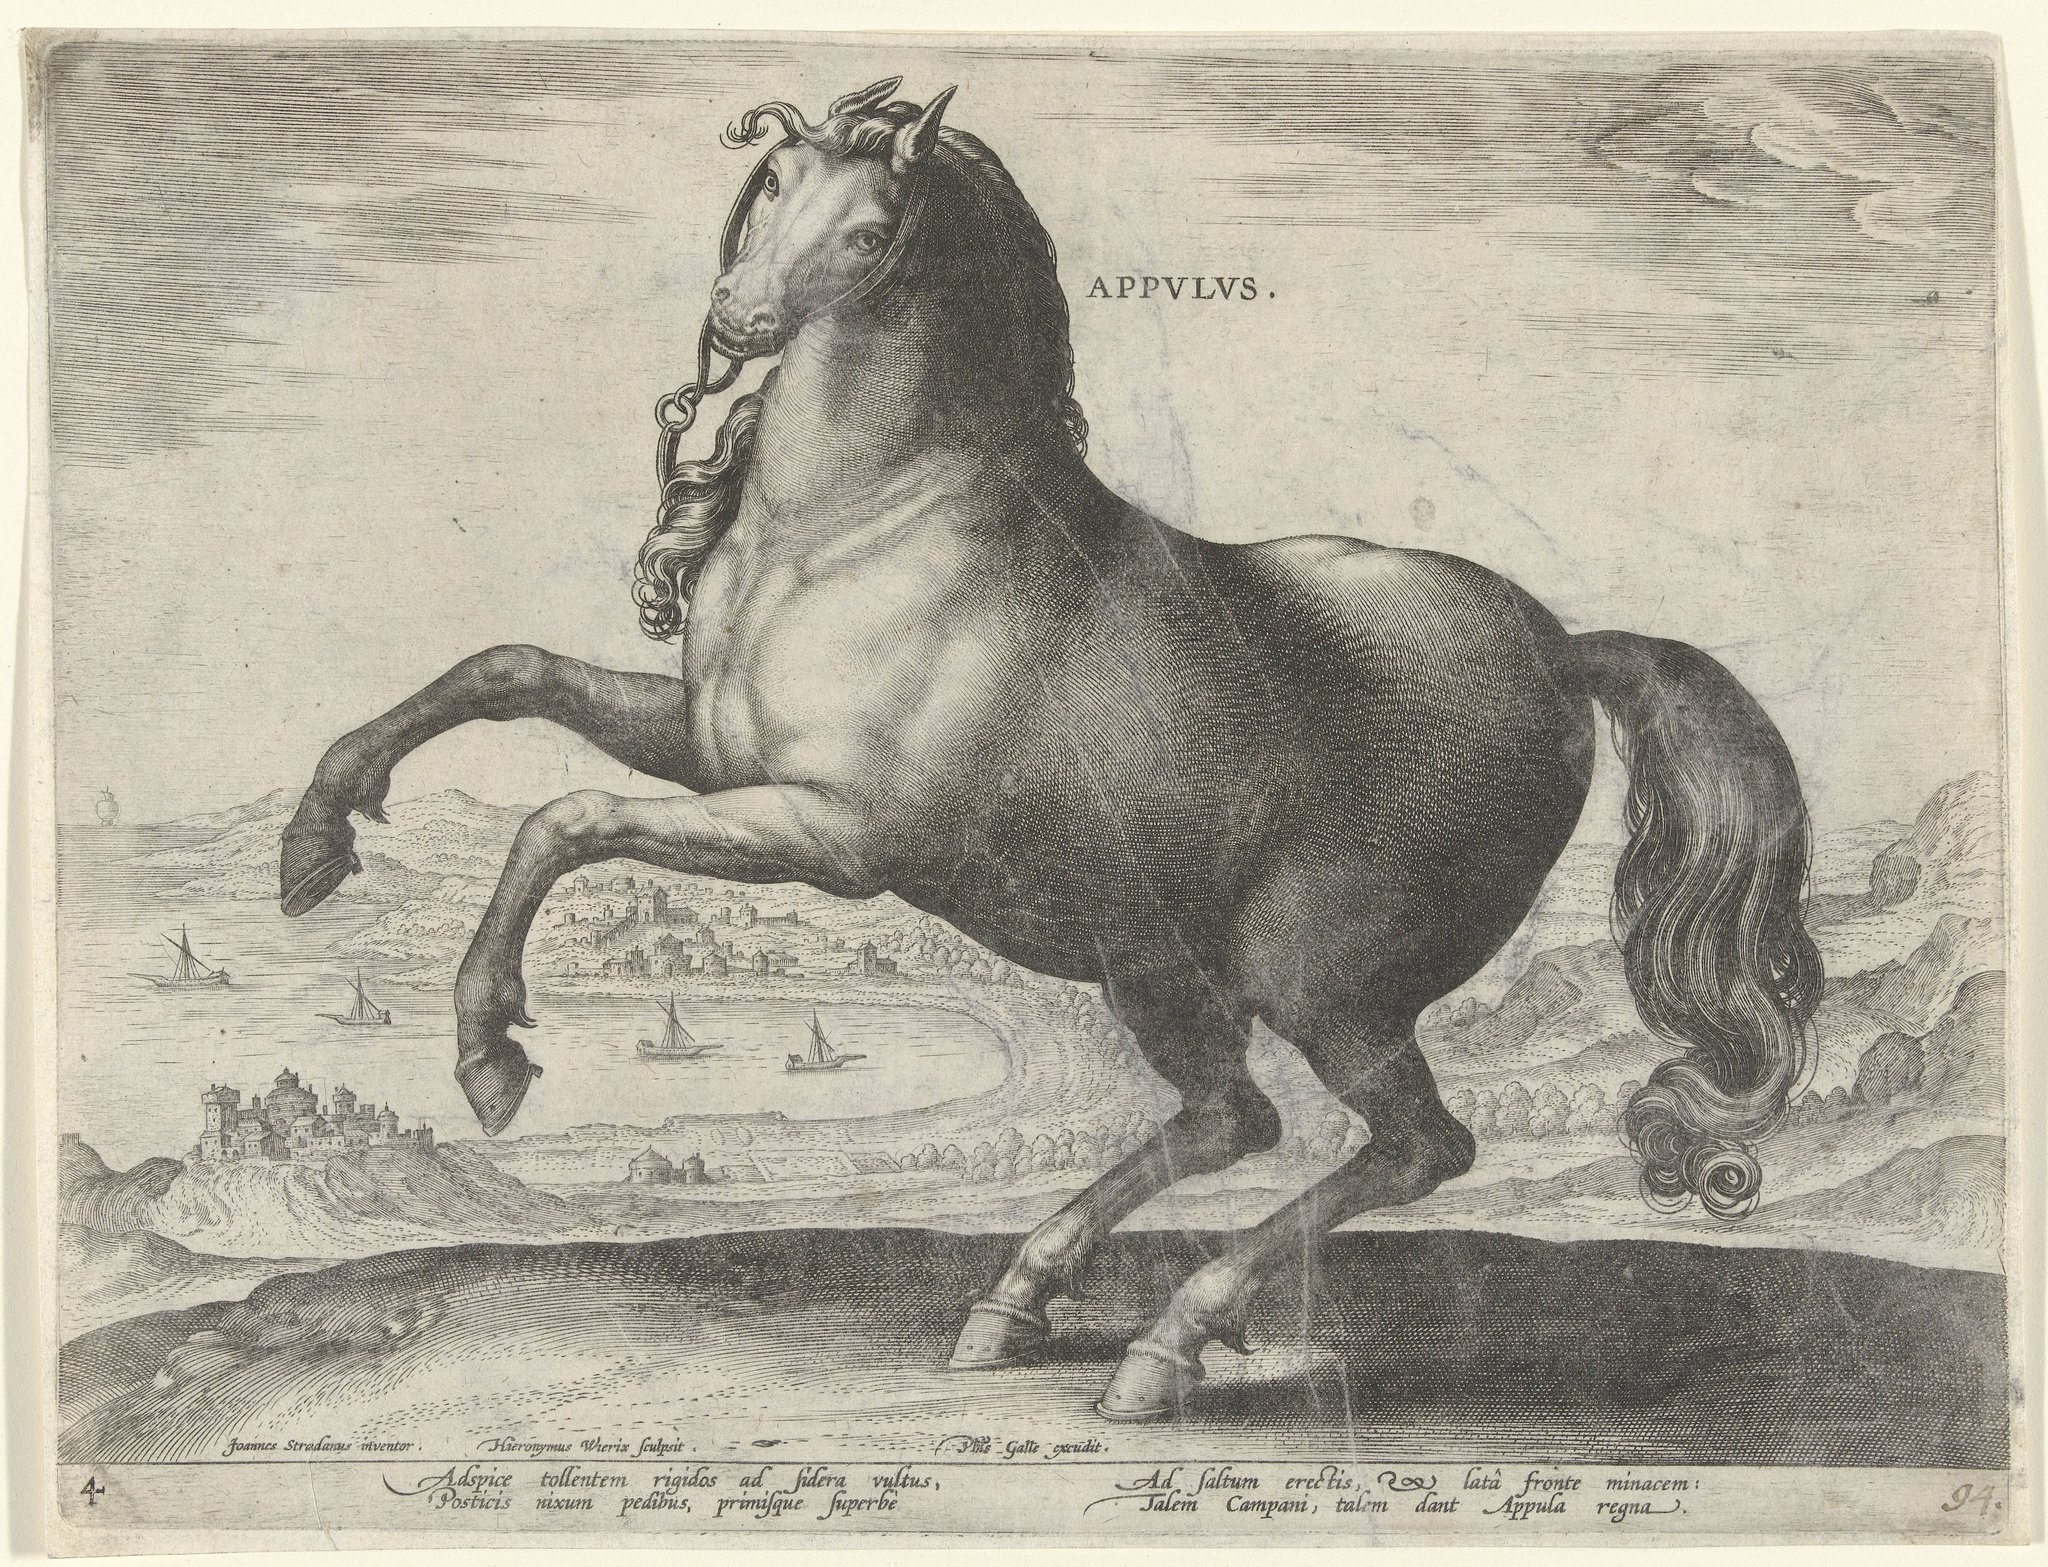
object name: print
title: Paard uit Zuid-Italië (Appulus)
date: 1583-1587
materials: paper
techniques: engraving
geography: antwerp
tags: don juan van oostenrijk, horses and kindred animals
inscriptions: collector's mark: Lugt 2228, number: ‘94’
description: Een Zuid-Italiaans paard (Appulus), in profiel. Het steigert. De prent heeft een Latijns onderschrift en maakt deel uit van het eerste deel van een 39-delige serie over de paardenrassen uit Koninklijke stallen van Don Juan van Oostenrijk.